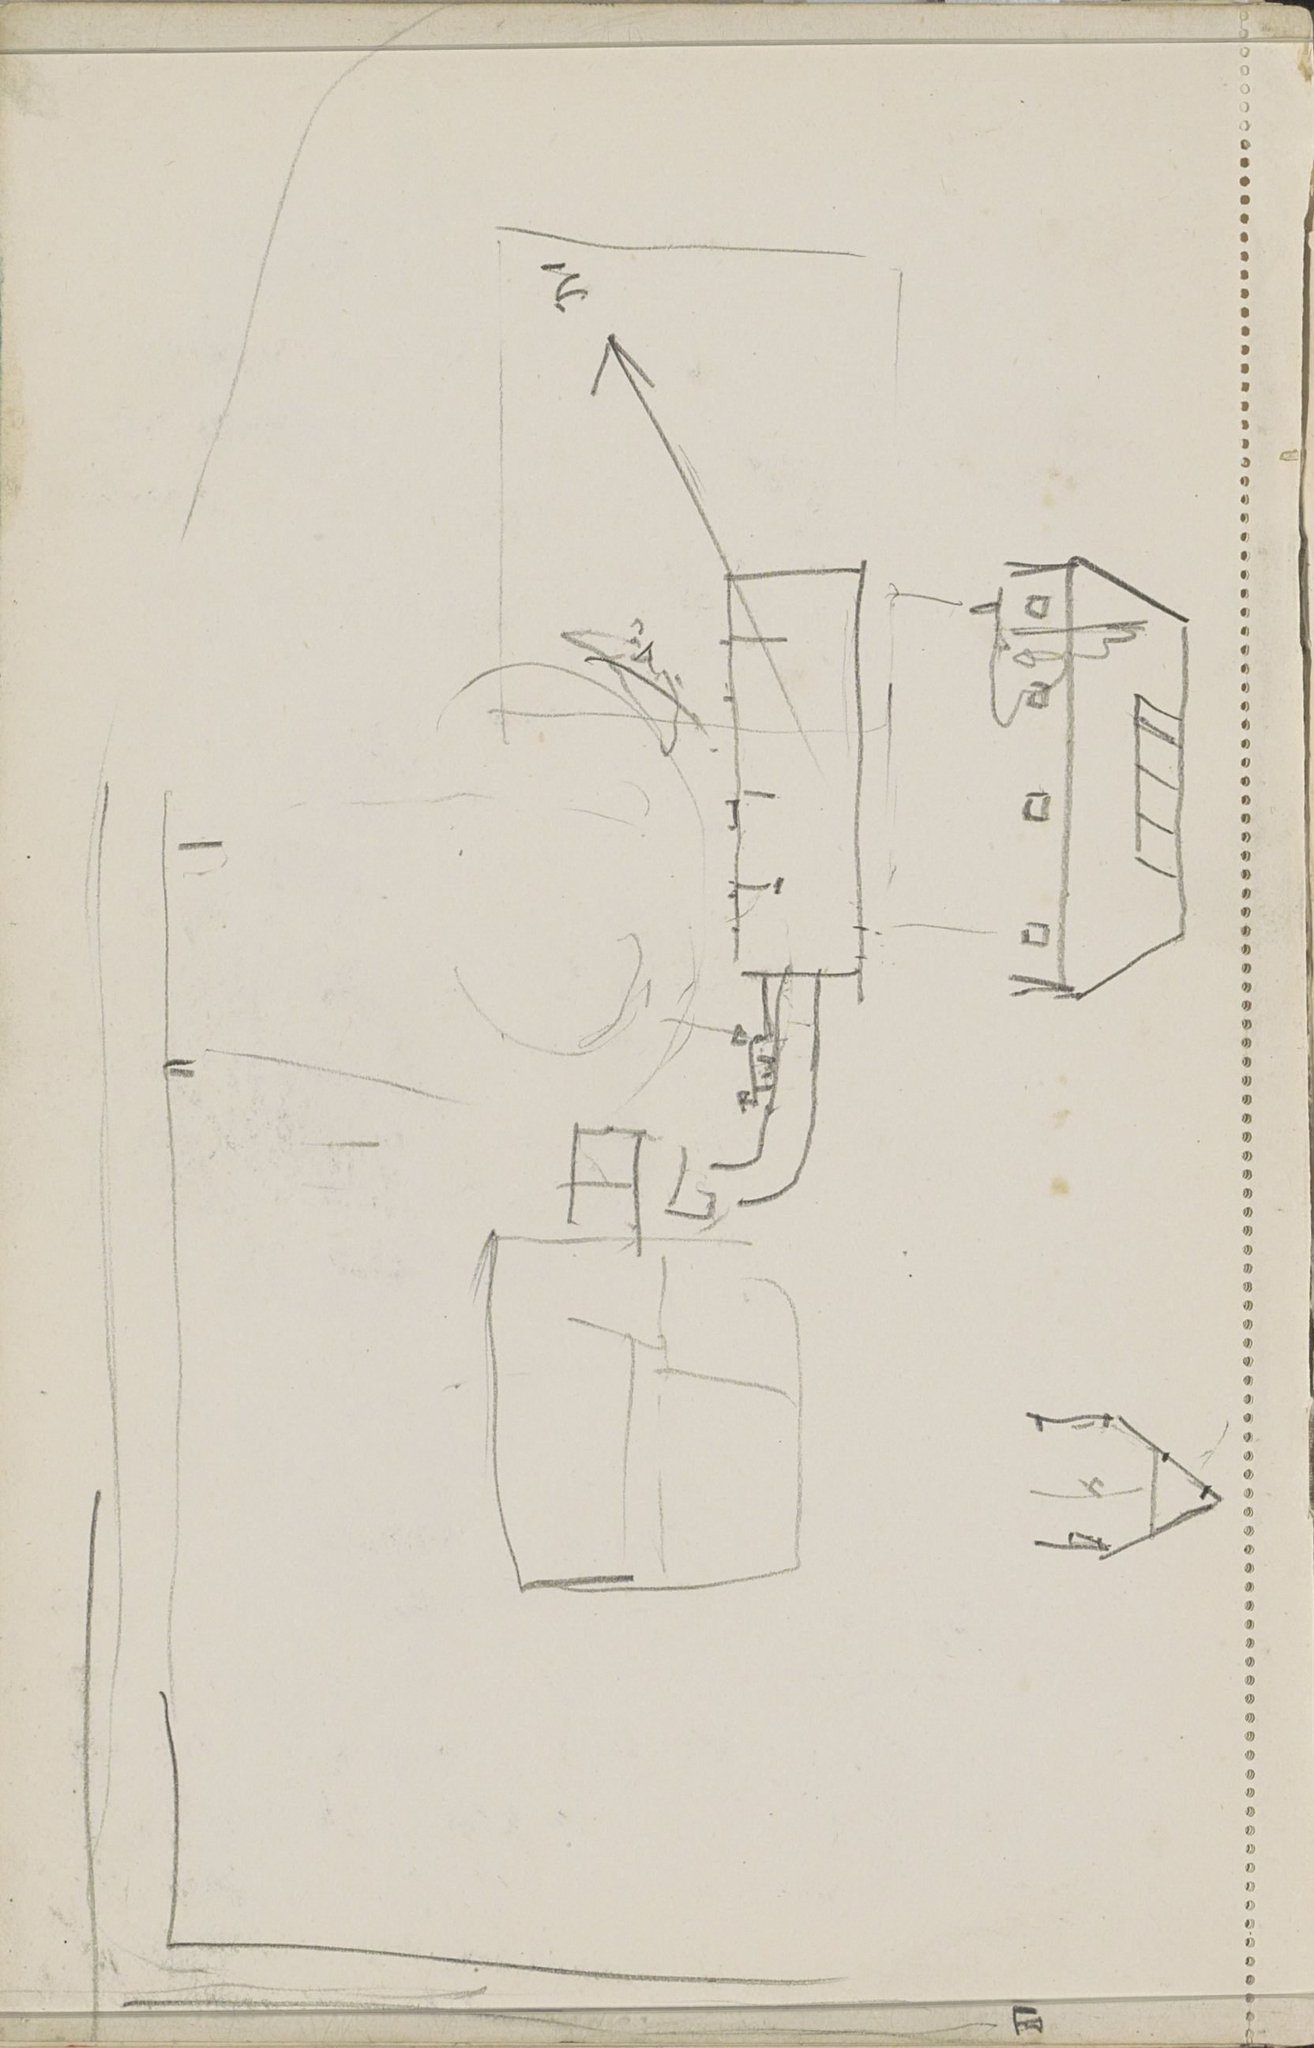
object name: sketchbook leaf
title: Architectuurstudies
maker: cornelis vreedenburgh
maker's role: draughtsman, print maker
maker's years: 1880-1946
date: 1890-1946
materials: paper, pencil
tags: architecture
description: Blad 57 verso uit een schetsboek met 61 bladen.